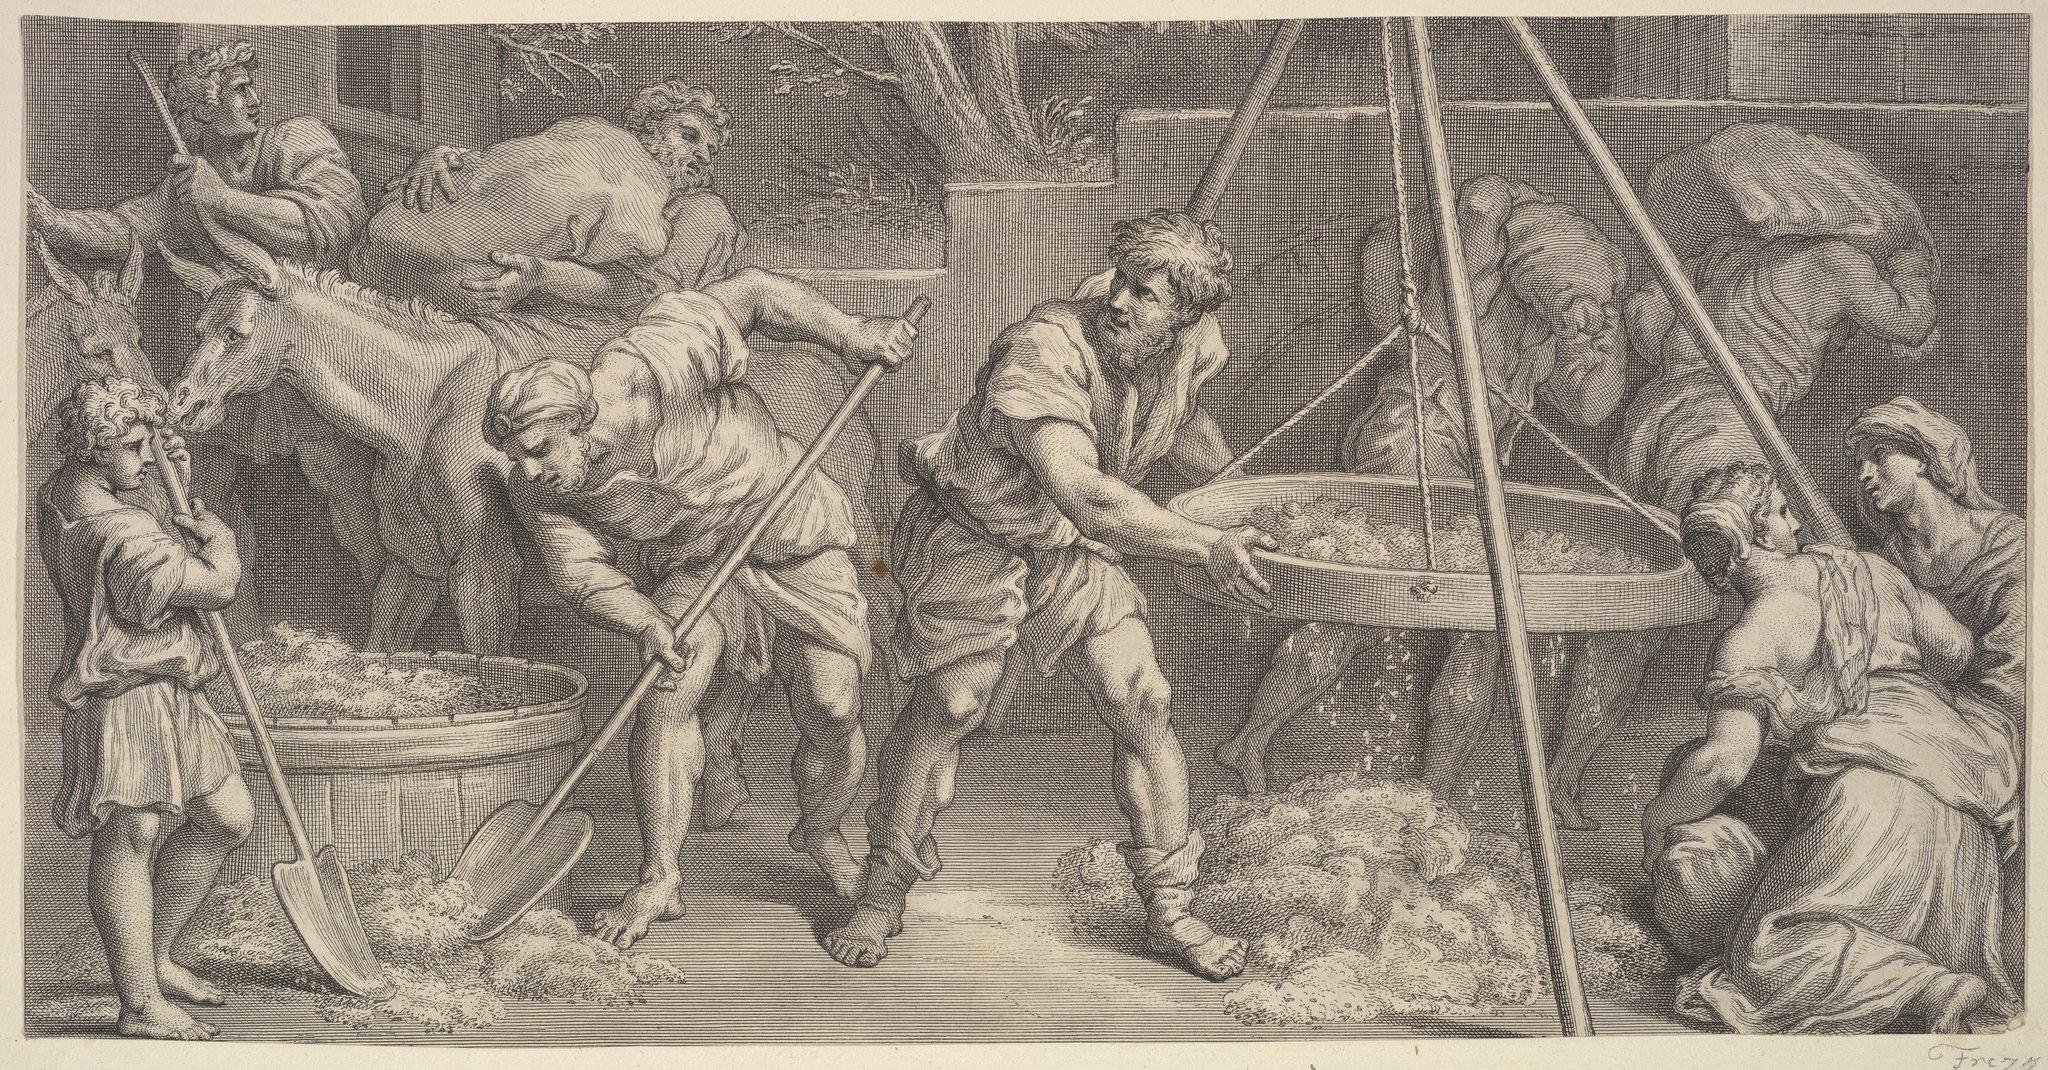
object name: print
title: Men with seive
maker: giovanni girolamo frezza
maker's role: artist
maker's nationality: italian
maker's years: 1671-1753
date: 1675-1741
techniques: engraving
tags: men,donkeys,working